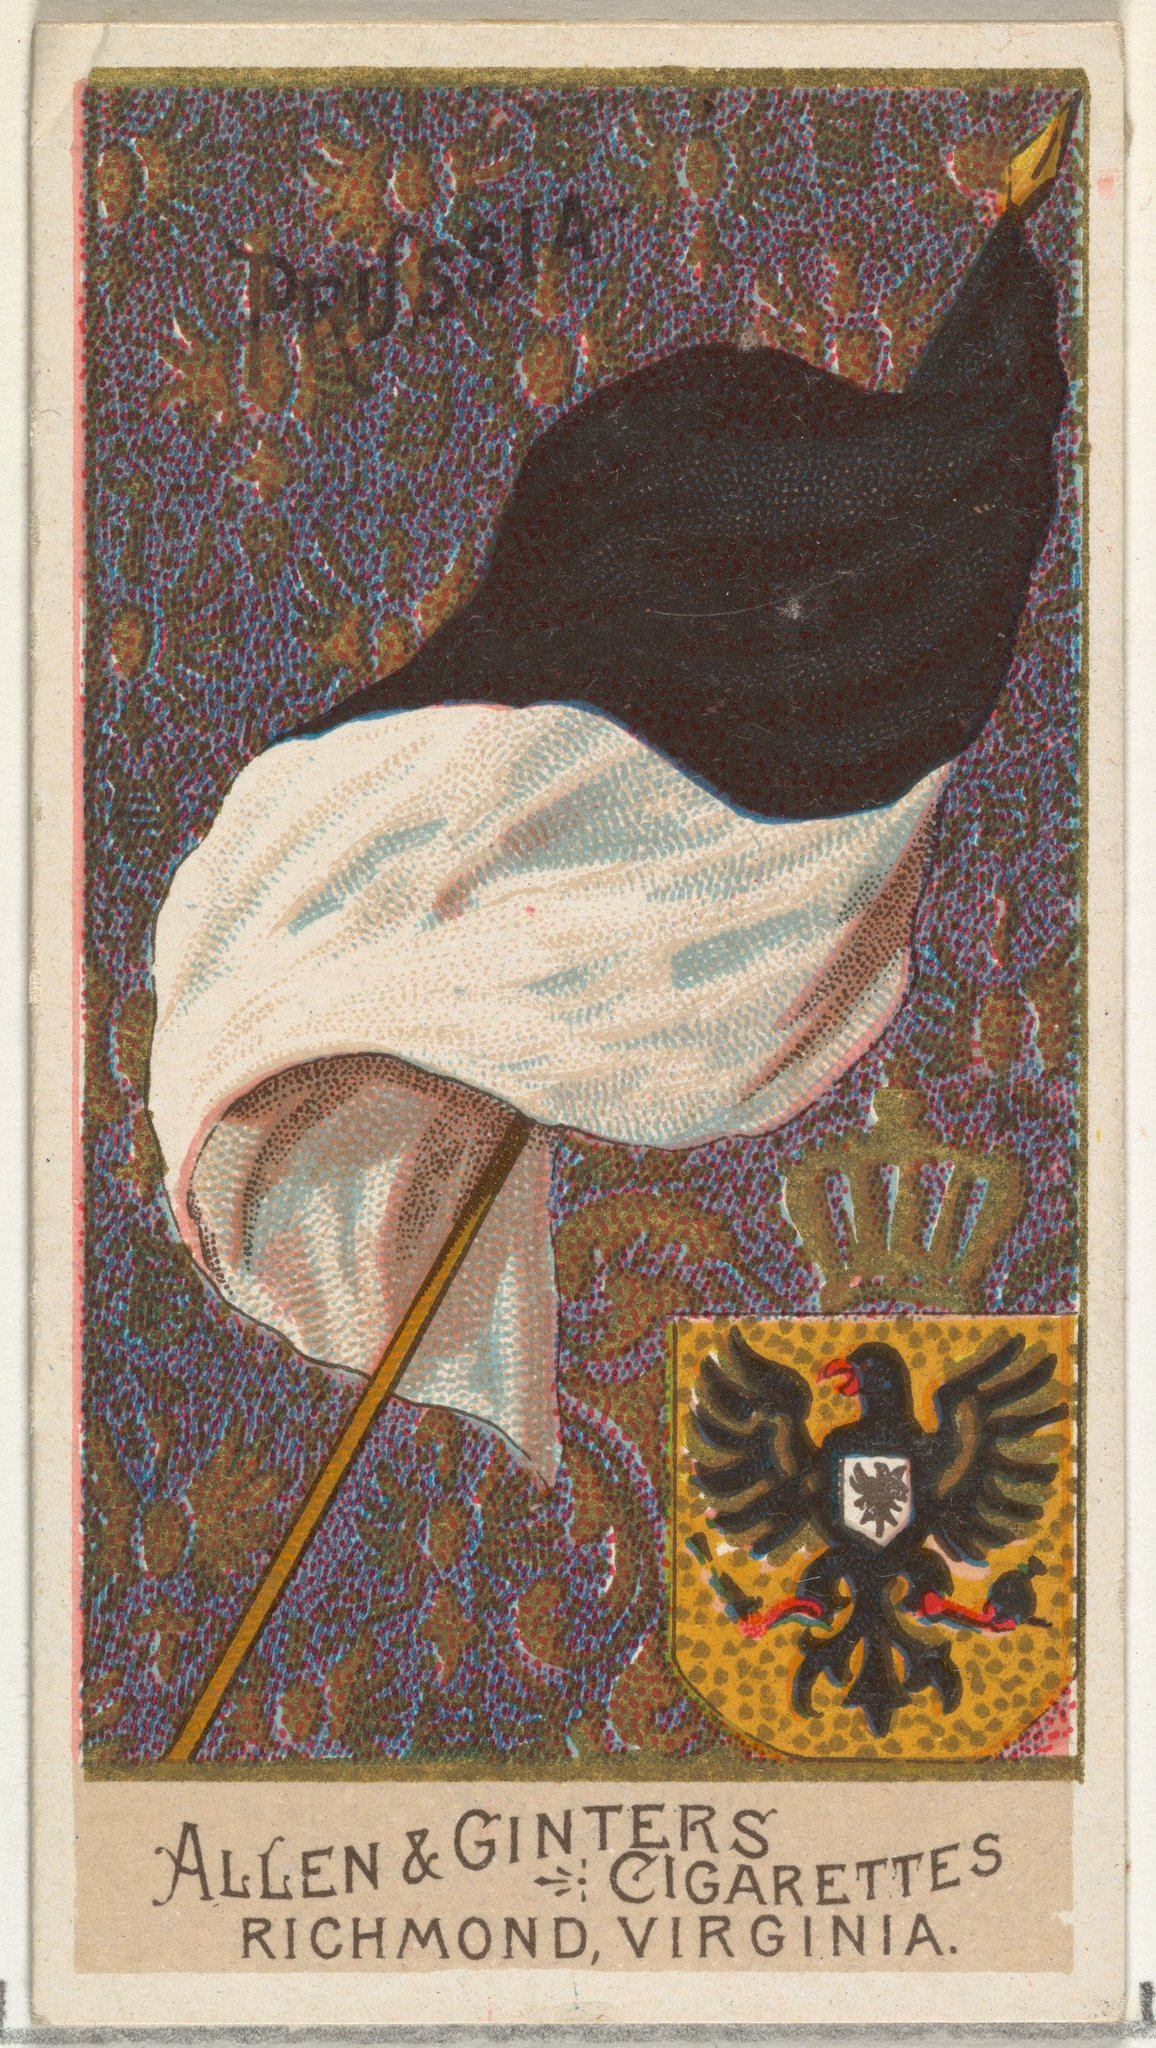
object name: print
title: Prussia, from Flags of All Nations, Series 2 (N10) for Allen & Ginter Cigarettes Brands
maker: allen & ginter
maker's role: publisher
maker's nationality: american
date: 1890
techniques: color lithograph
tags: coat of arms,flags